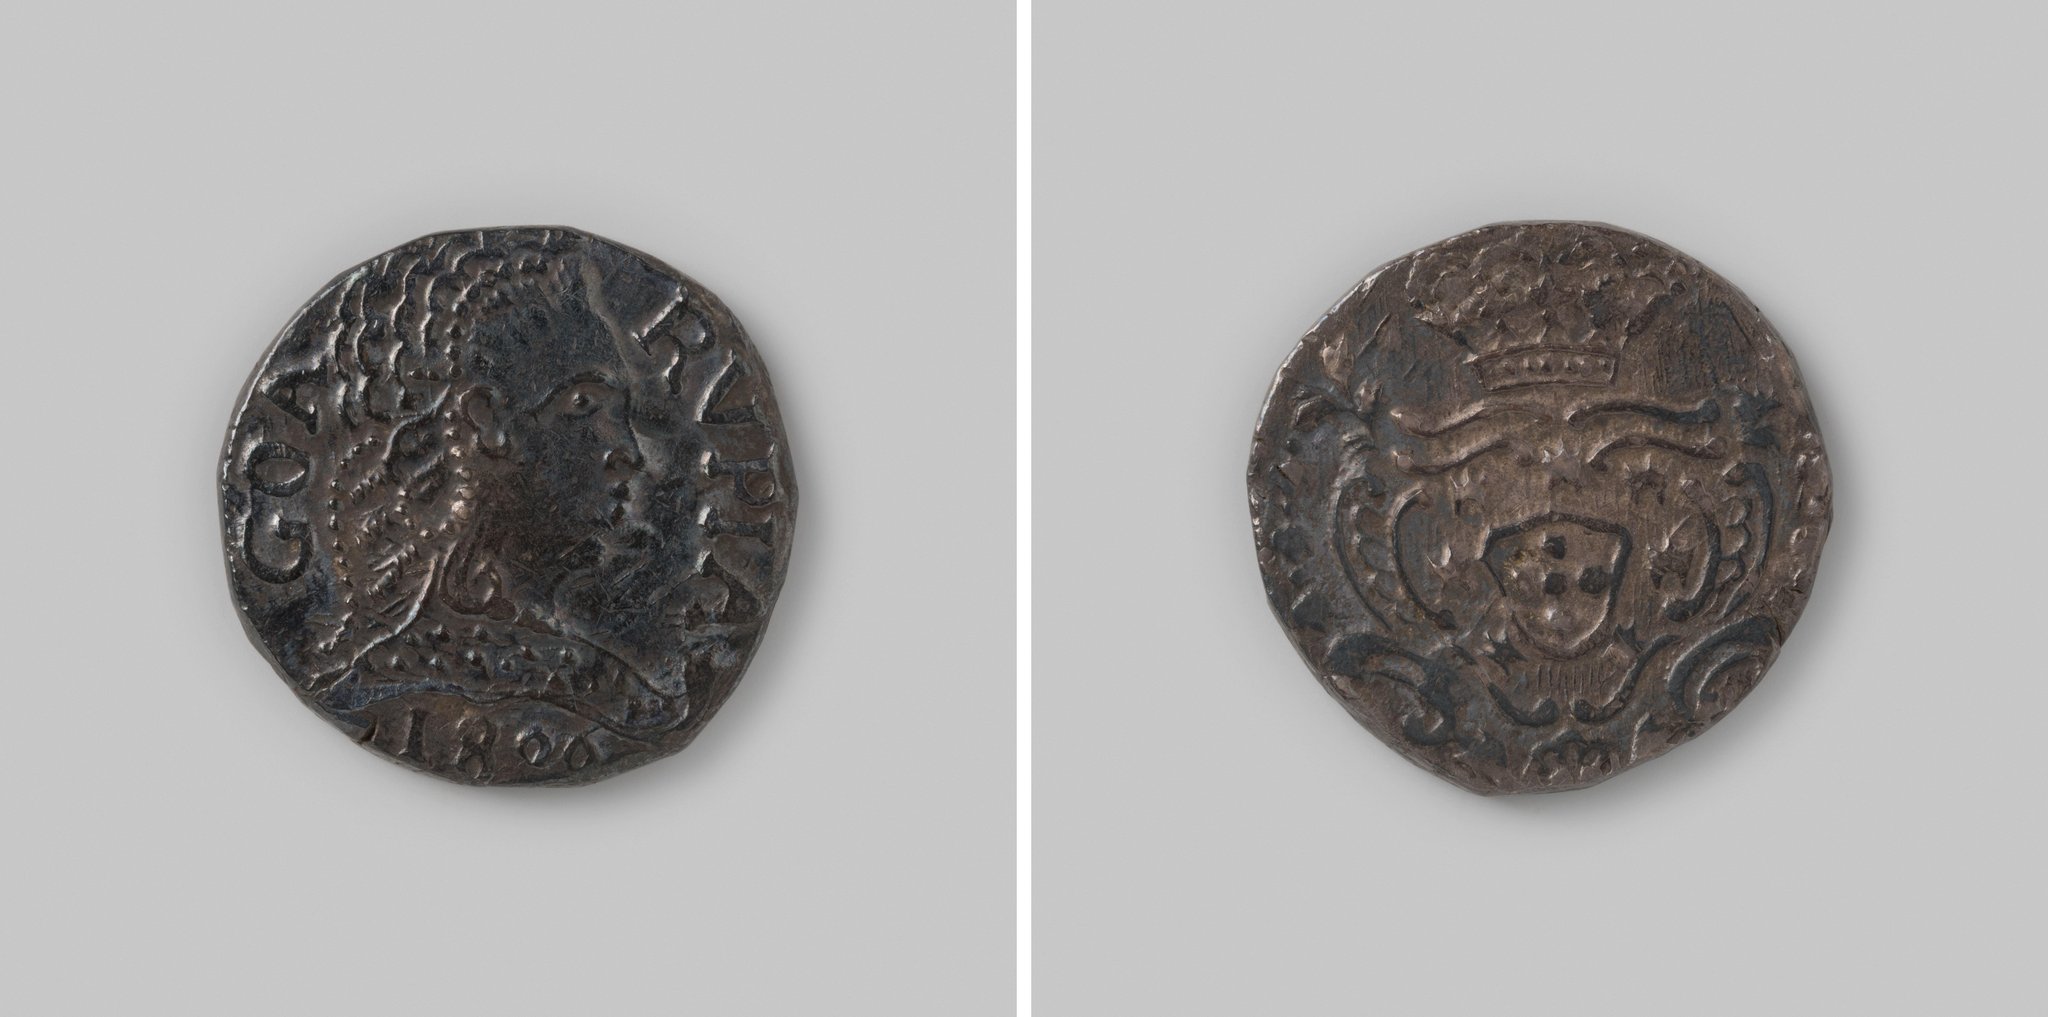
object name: coin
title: Rupia of 2 pardaos uit Goa, Portugees India van koningin Maria I, 1800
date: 1800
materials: silver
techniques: striking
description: Zilveren munt. Voorzijde: hoofd naar rechts. Daaronder jaartal. Waarde-aanduiding: rvpia in omschrift. Keerzijde: gekroond versierd wapenschild van Portugal. Gladde rand.